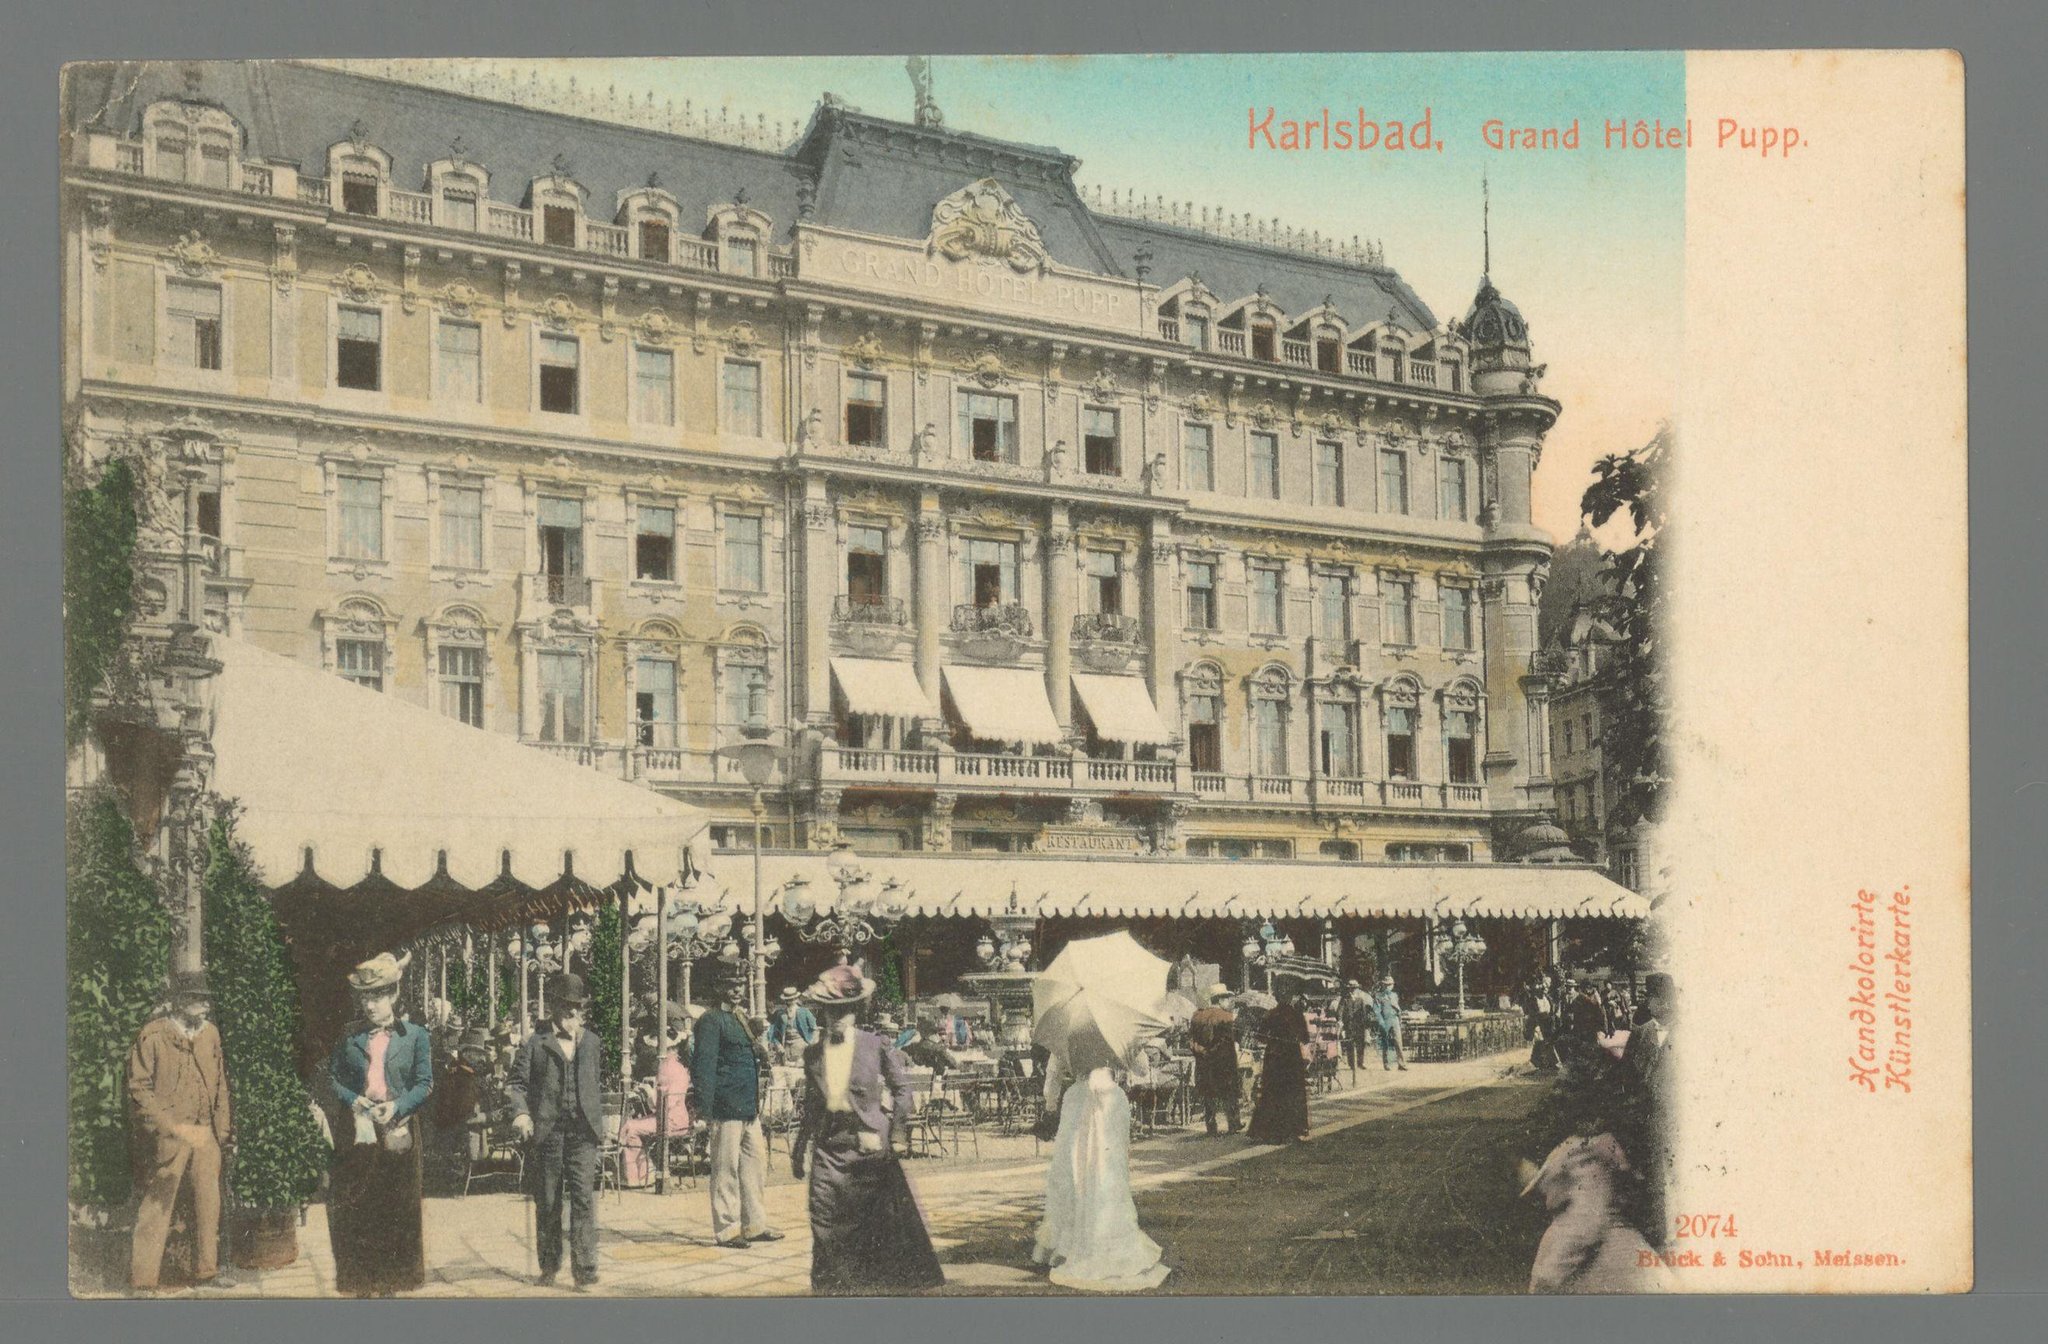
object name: photomechanical print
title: Karlsbad. Grand Hôtel Pupp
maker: Anonymous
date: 1885-1903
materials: cardboard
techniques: photograph, lithograph, hand coloring, writing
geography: meissen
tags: hotel, hostelry, inn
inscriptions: postage stamp